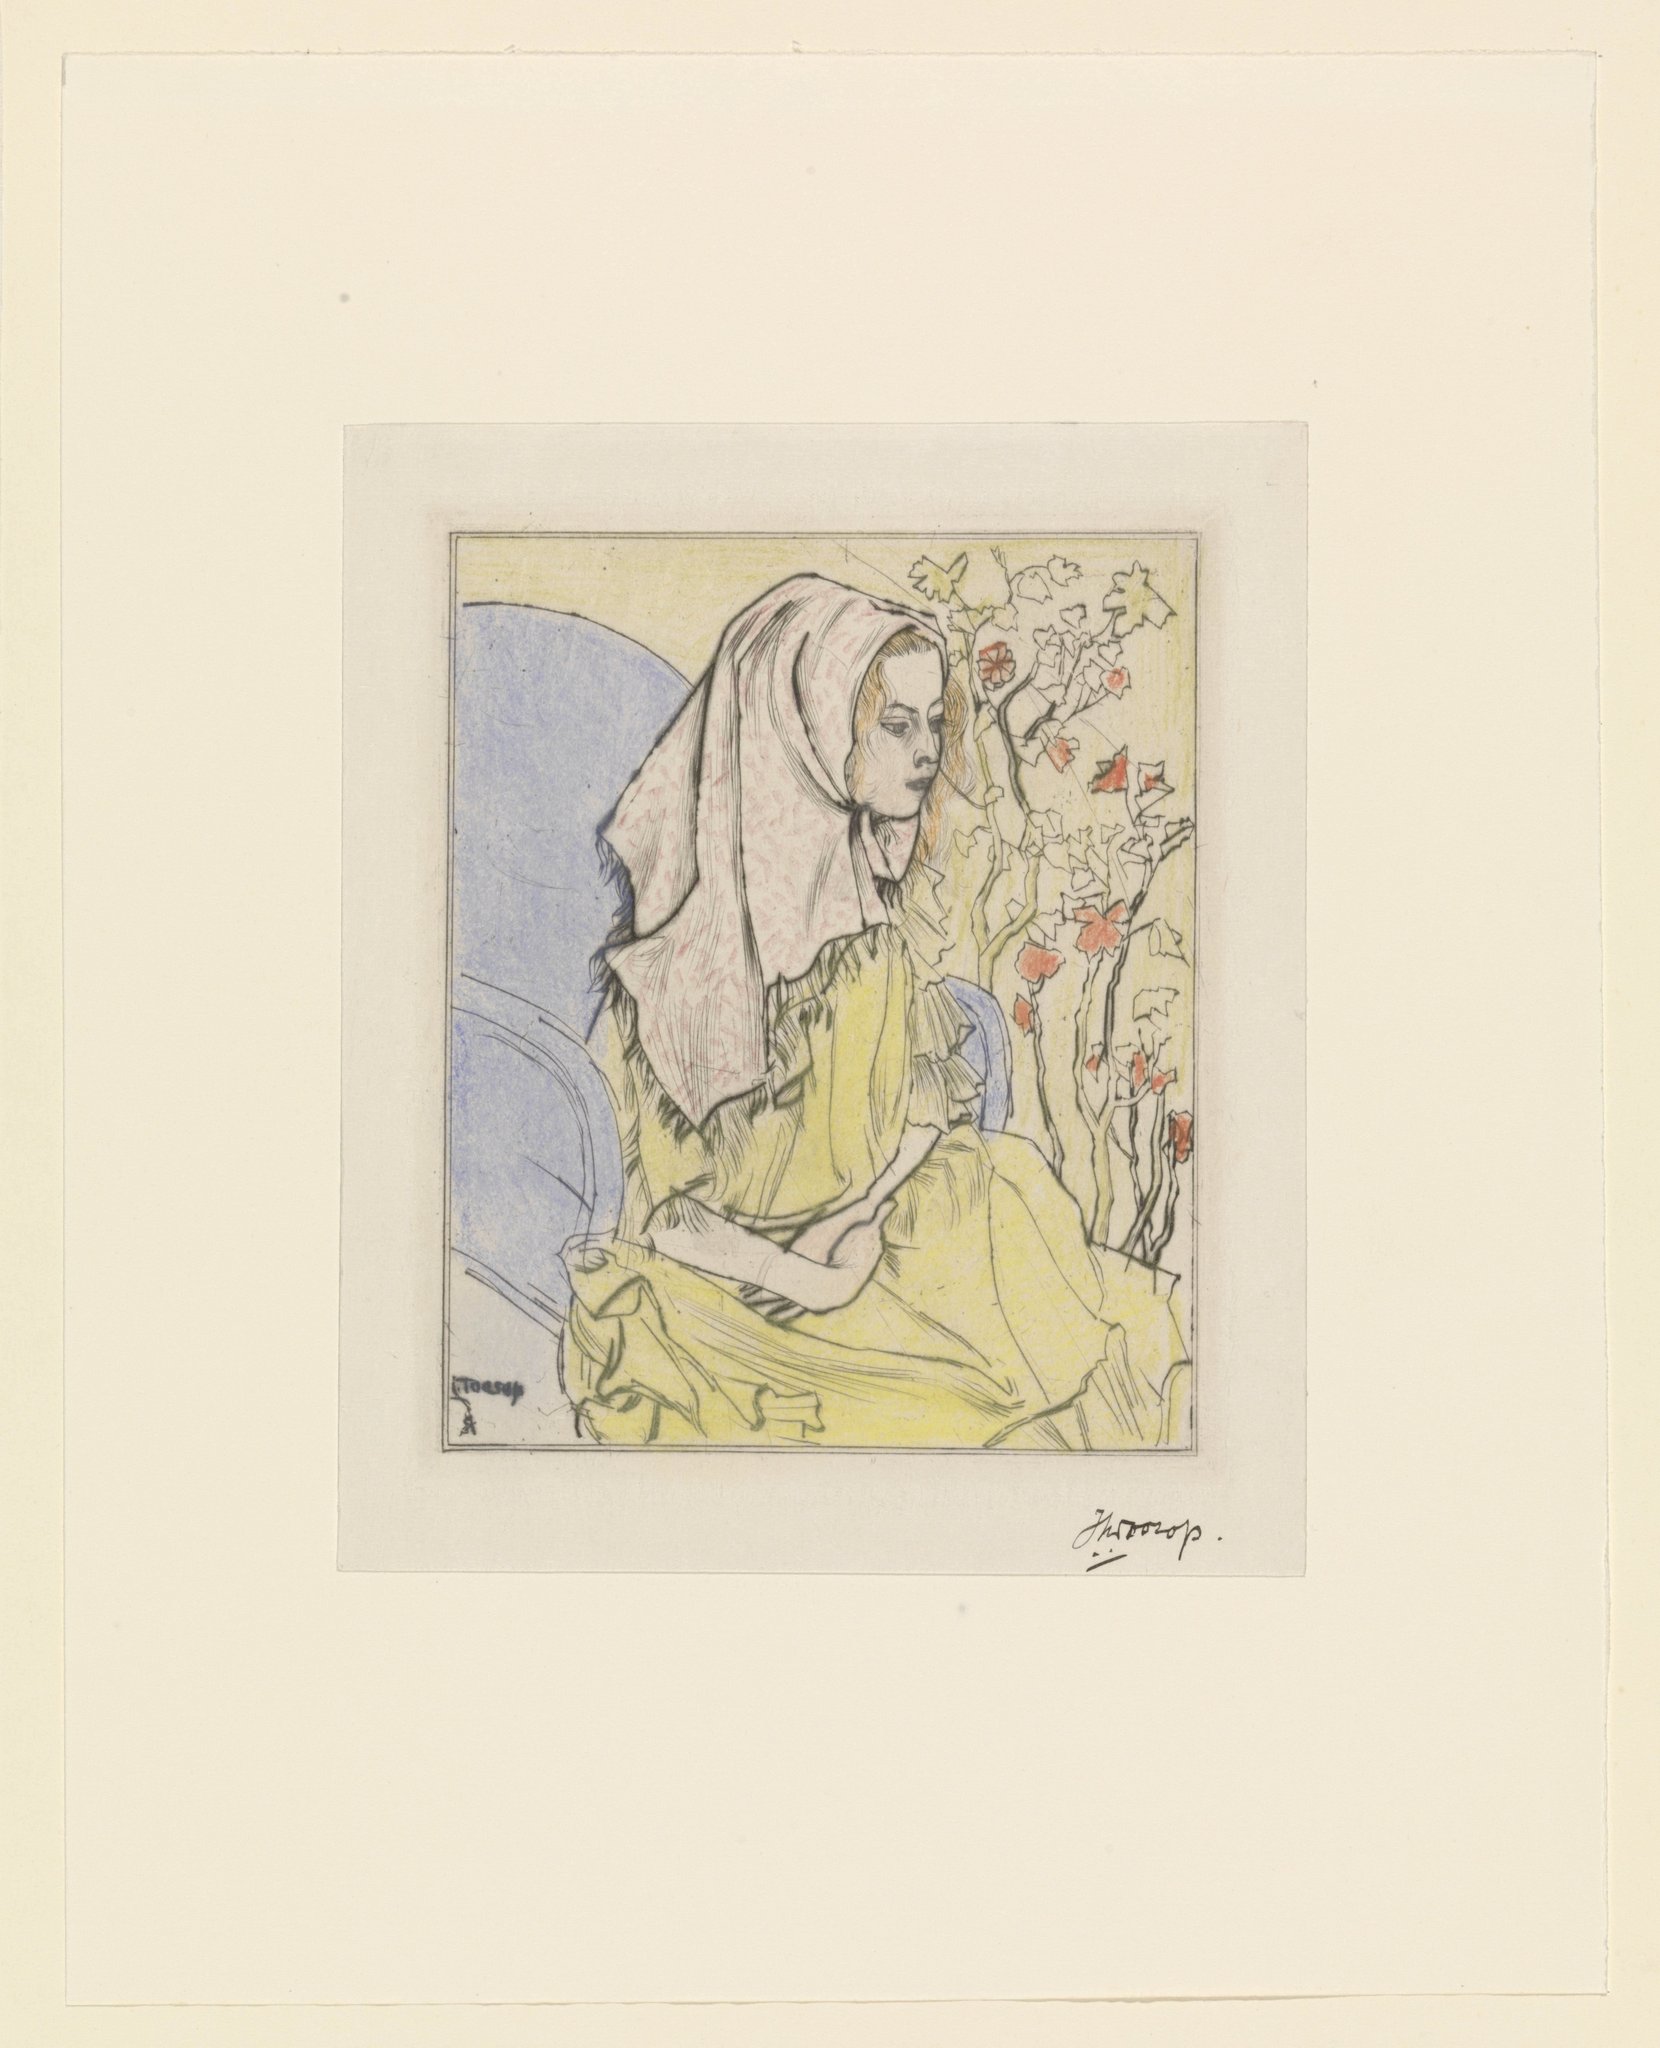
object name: print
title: Charley Toorop met hoofddoek in een leunstoel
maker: jan toorop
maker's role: draughtsman, painter, print maker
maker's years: 1858-1928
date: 1898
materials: chalk, paper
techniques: drypoint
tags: print maker, draughtsman, charley toorop, historical persons, girl (child between toddler and youth), patient, sick person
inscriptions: collector's mark: ‘g’, collector's mark: Lugt 2228